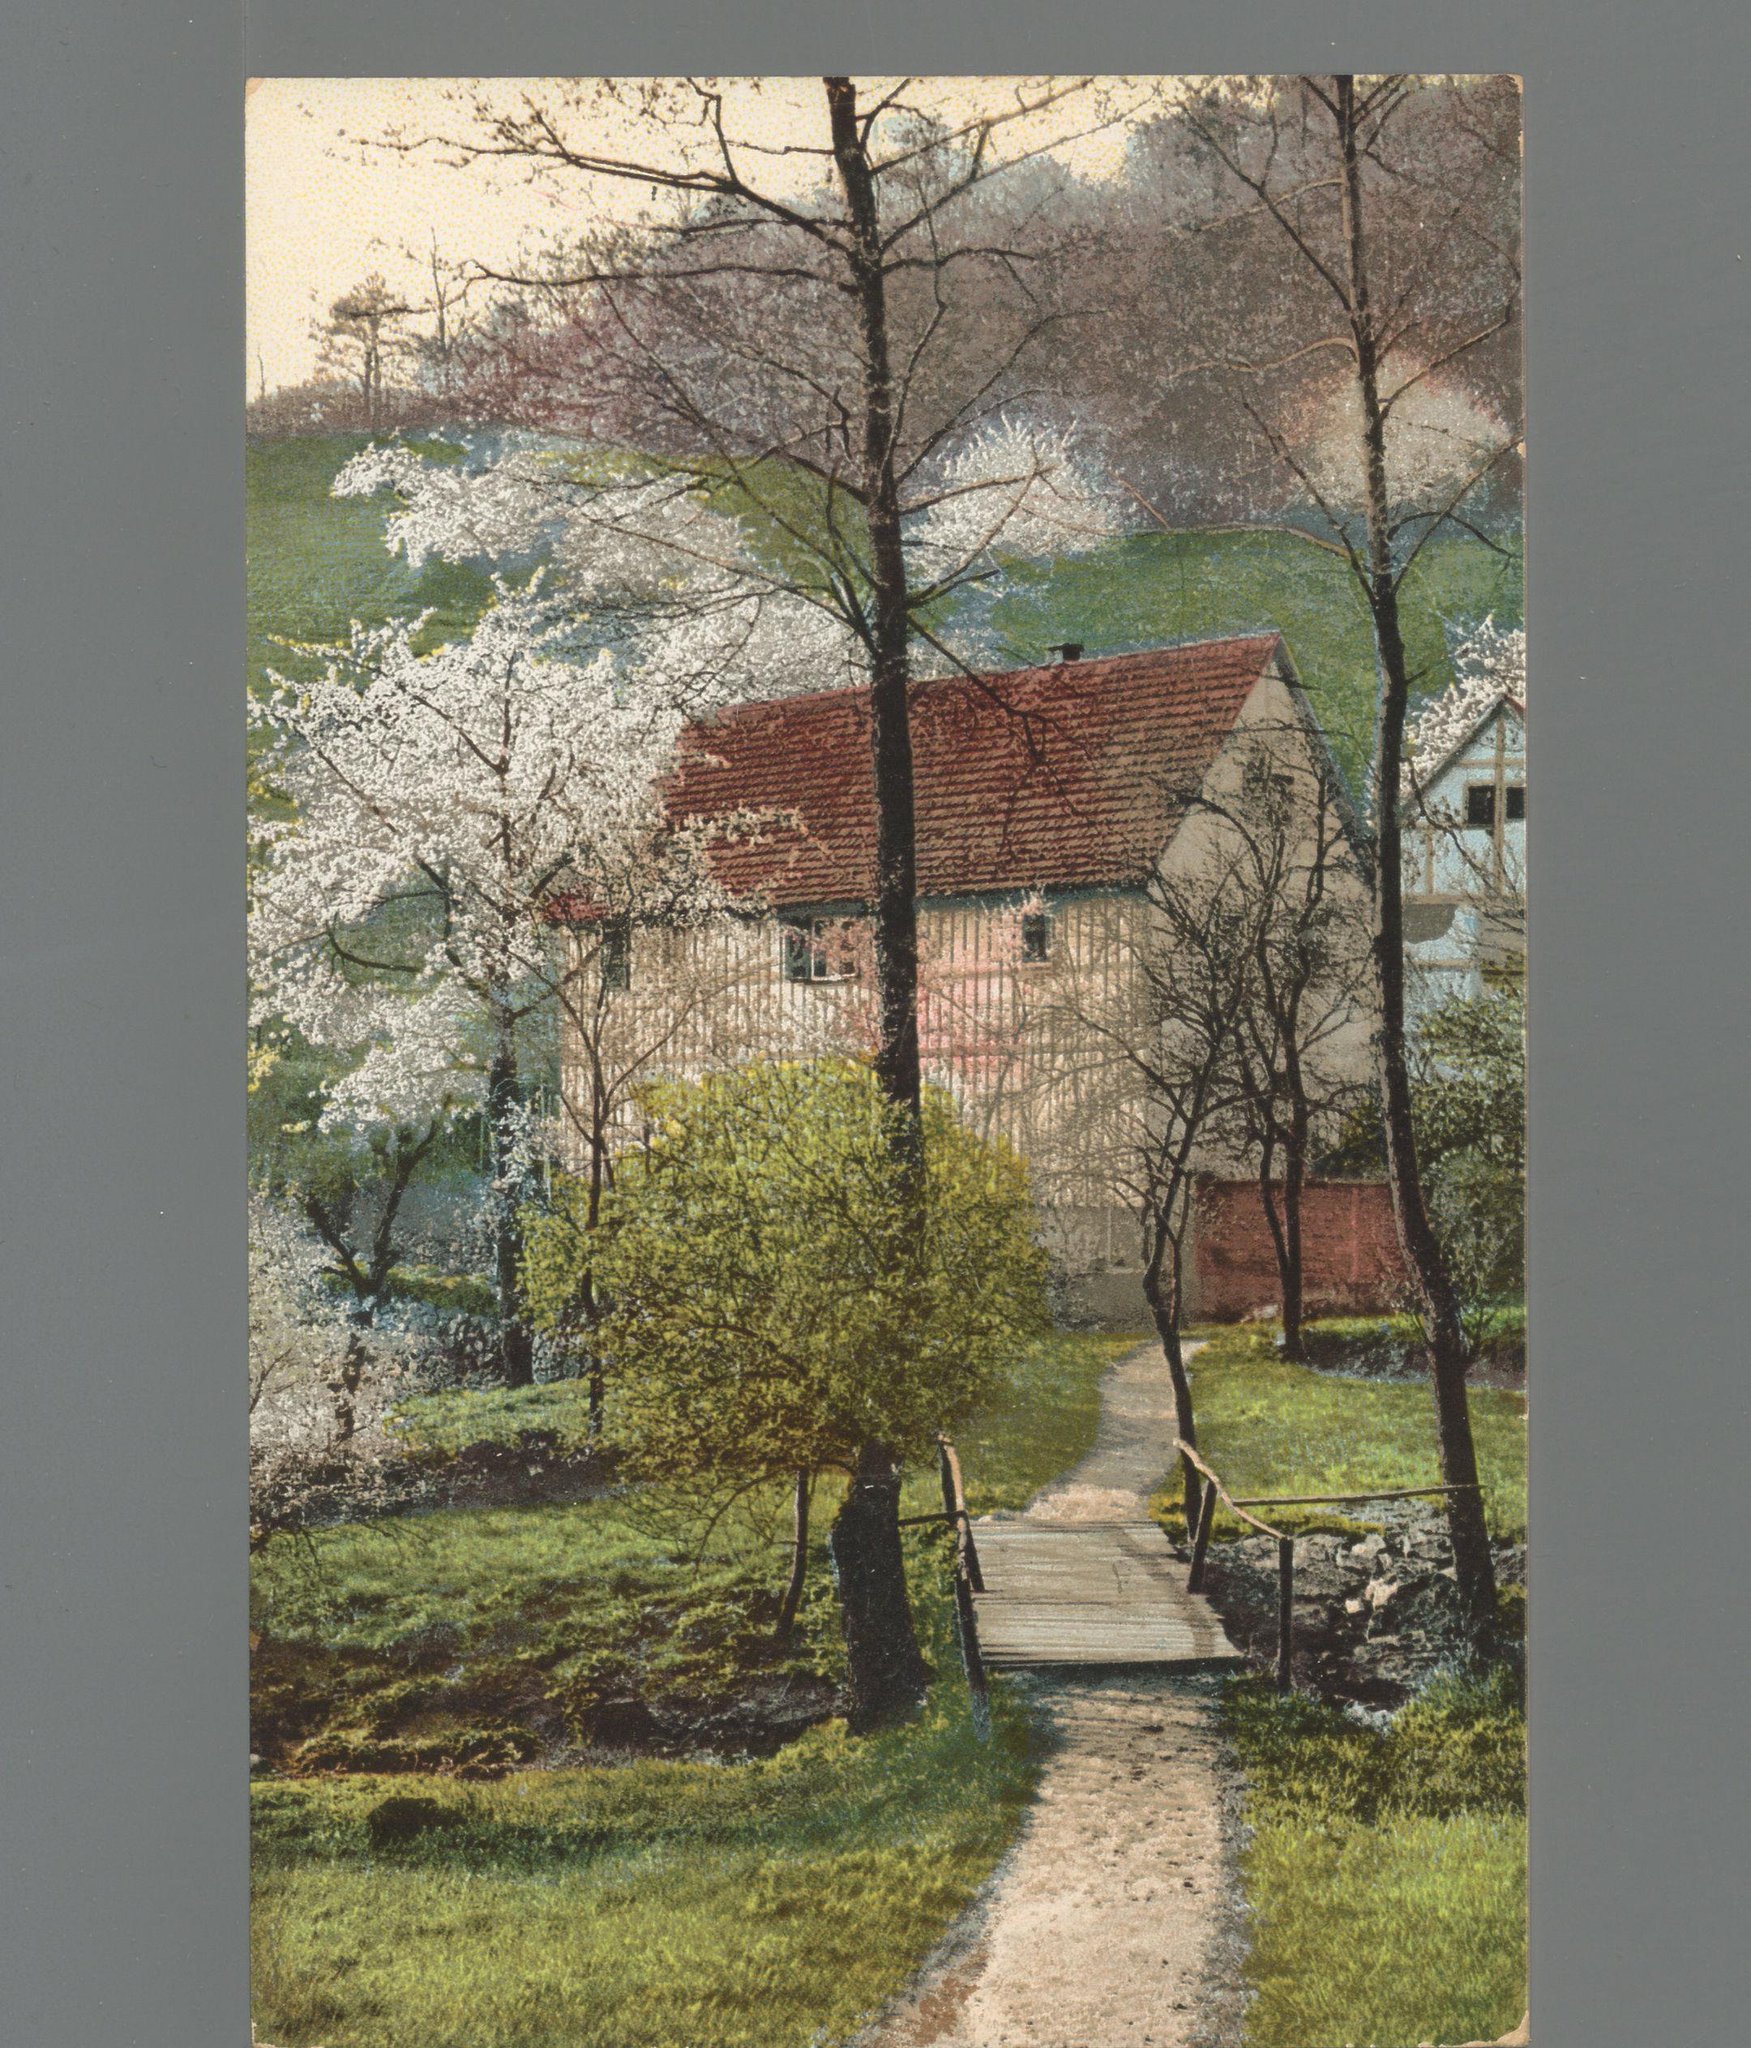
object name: ansichtkaart, prentbriefkaart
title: Gezicht op een huis in bosrijk gebied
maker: Anonymous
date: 1905-1933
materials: cardboard, photographic process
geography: germany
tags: rural housing, e.g. country-house, villa, cottage, bridge, germany